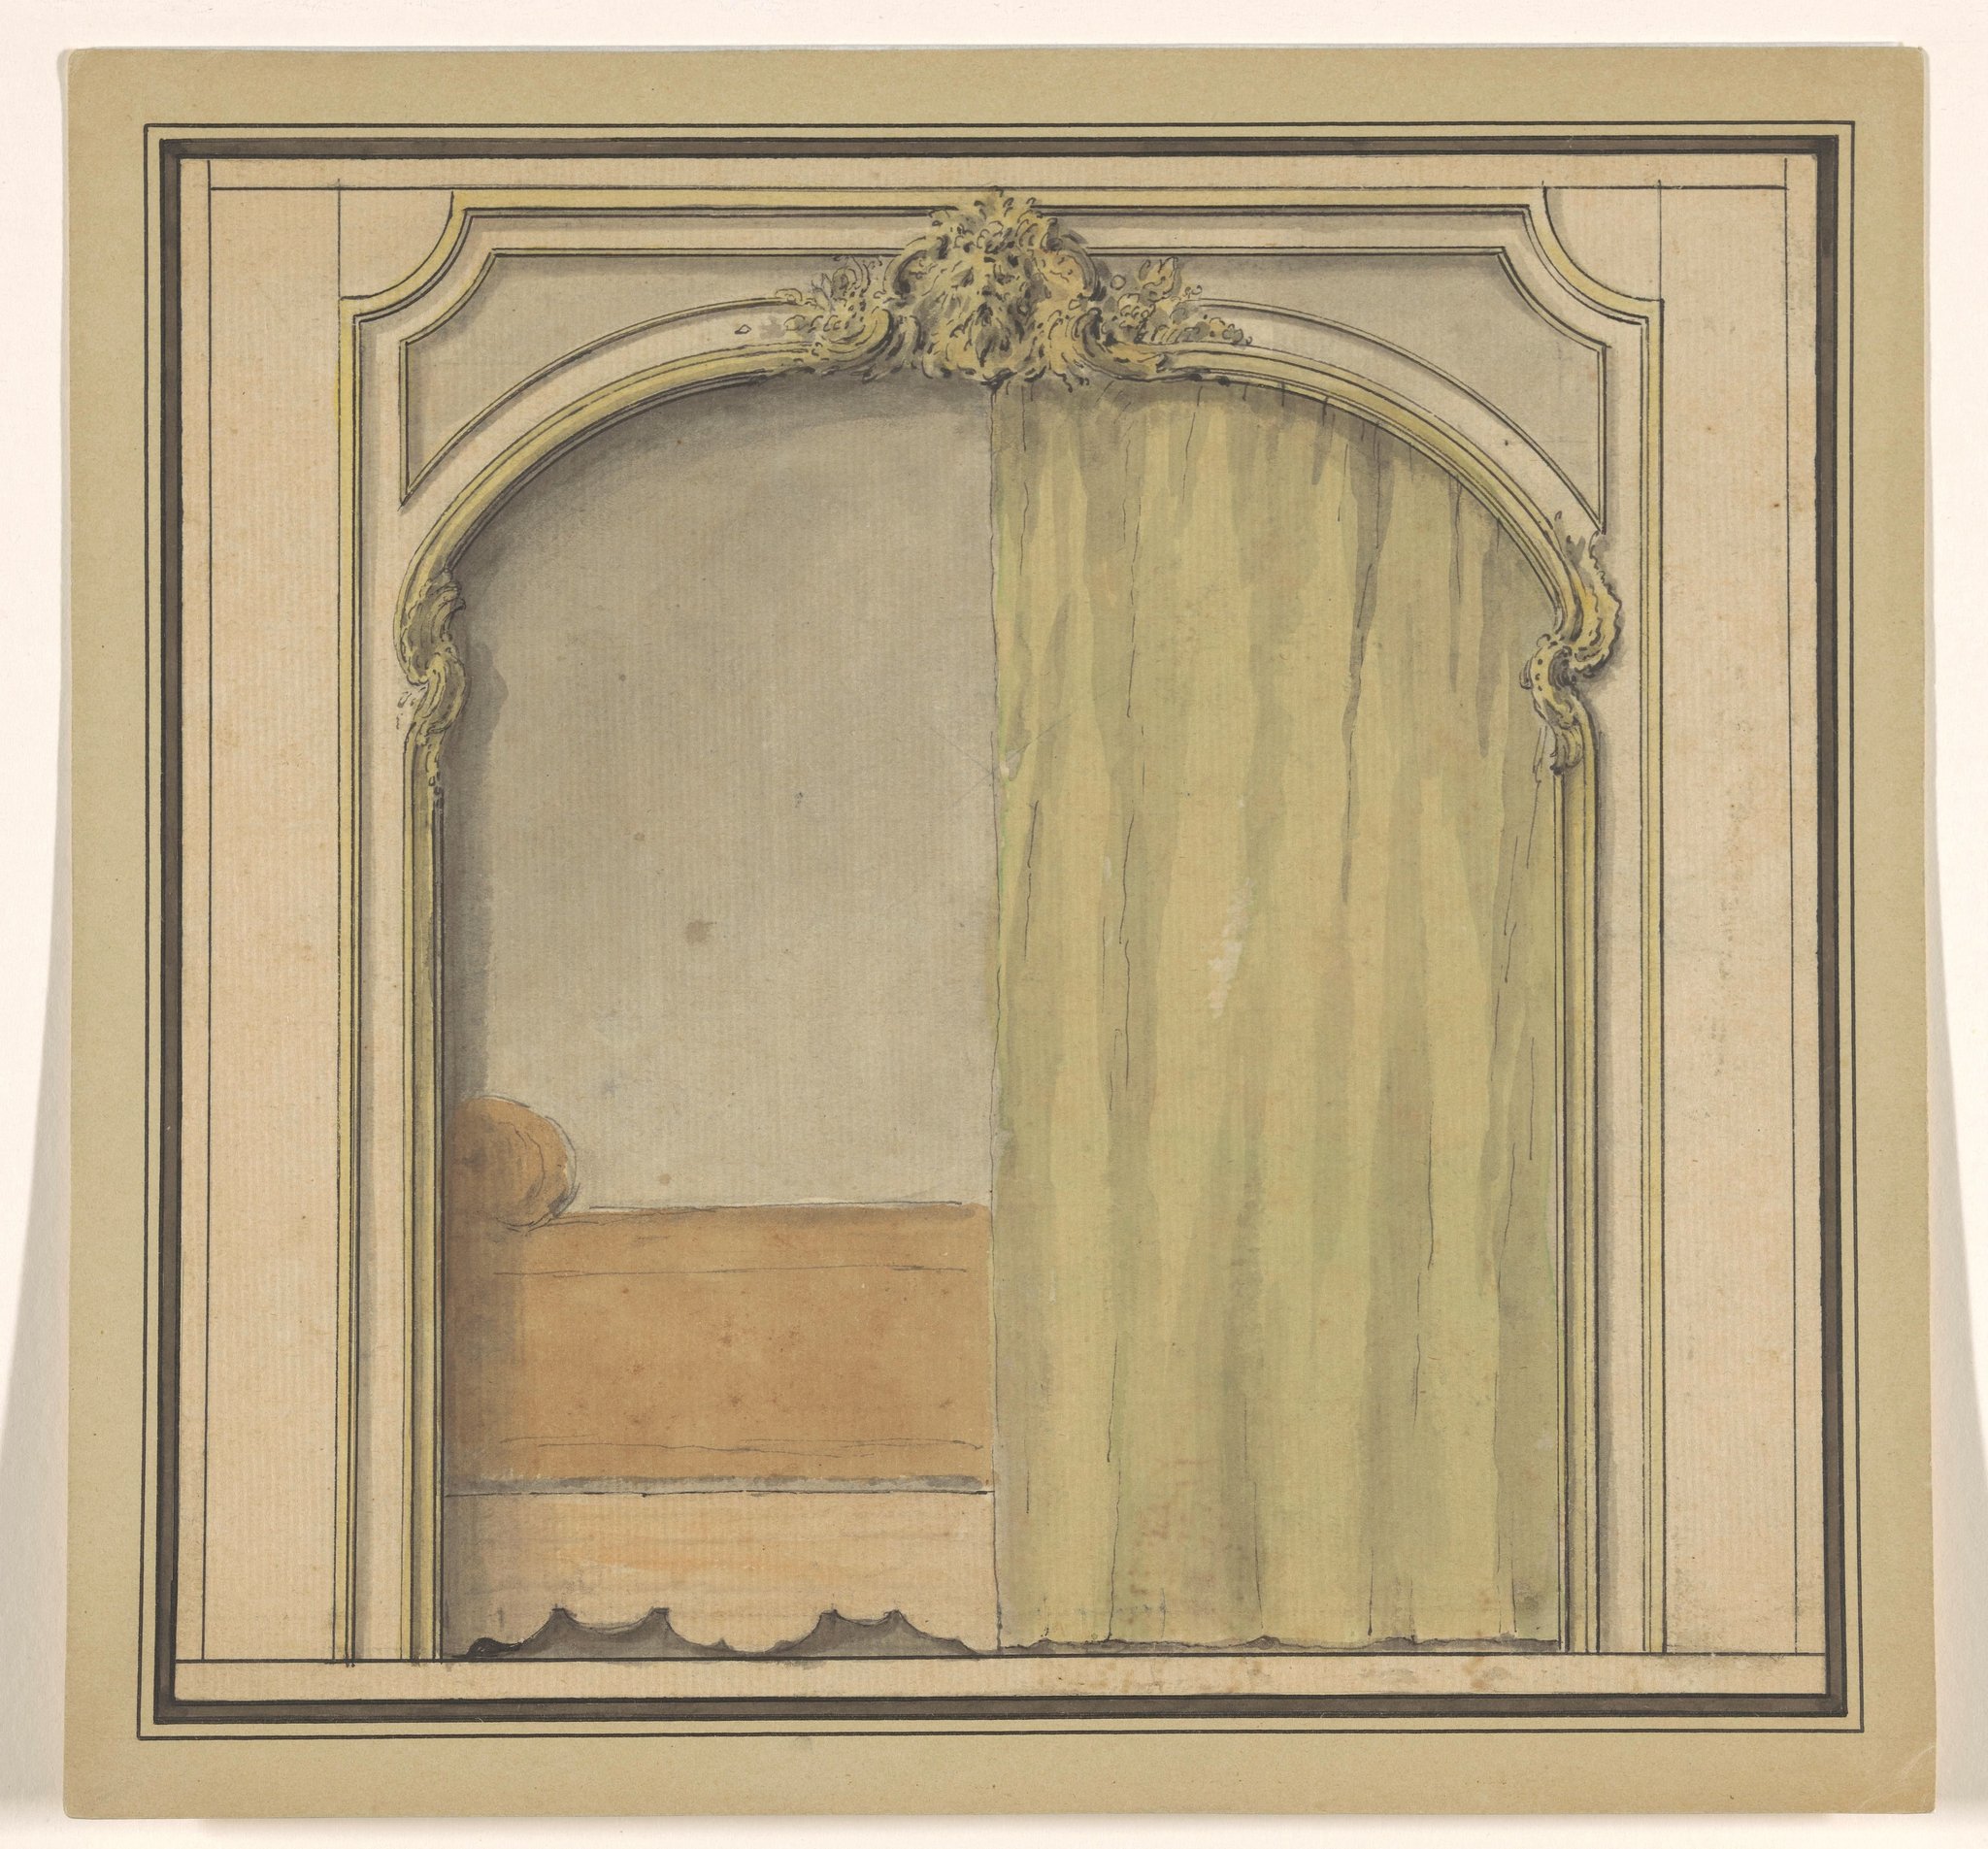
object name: drawing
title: Ontwerptekening voor een met een gebaard masker versierde nis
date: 1735-1750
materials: cardboard, graphite, ink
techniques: brush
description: Een met een gebaard masker versierde nis met een gedeeltelijk terzijde geschoven gordijn, waarachter een bed tevoorschijn komt.